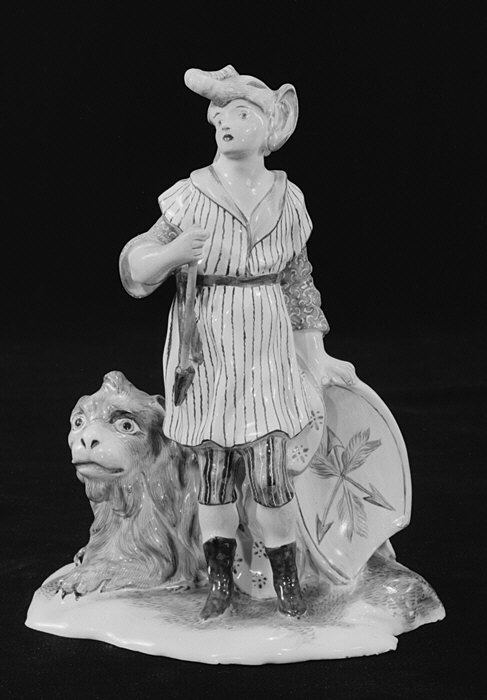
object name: group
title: Boy with lion (representing Africa) (part of a set)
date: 1755-1770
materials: faience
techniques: glazing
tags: shields,boys,lions